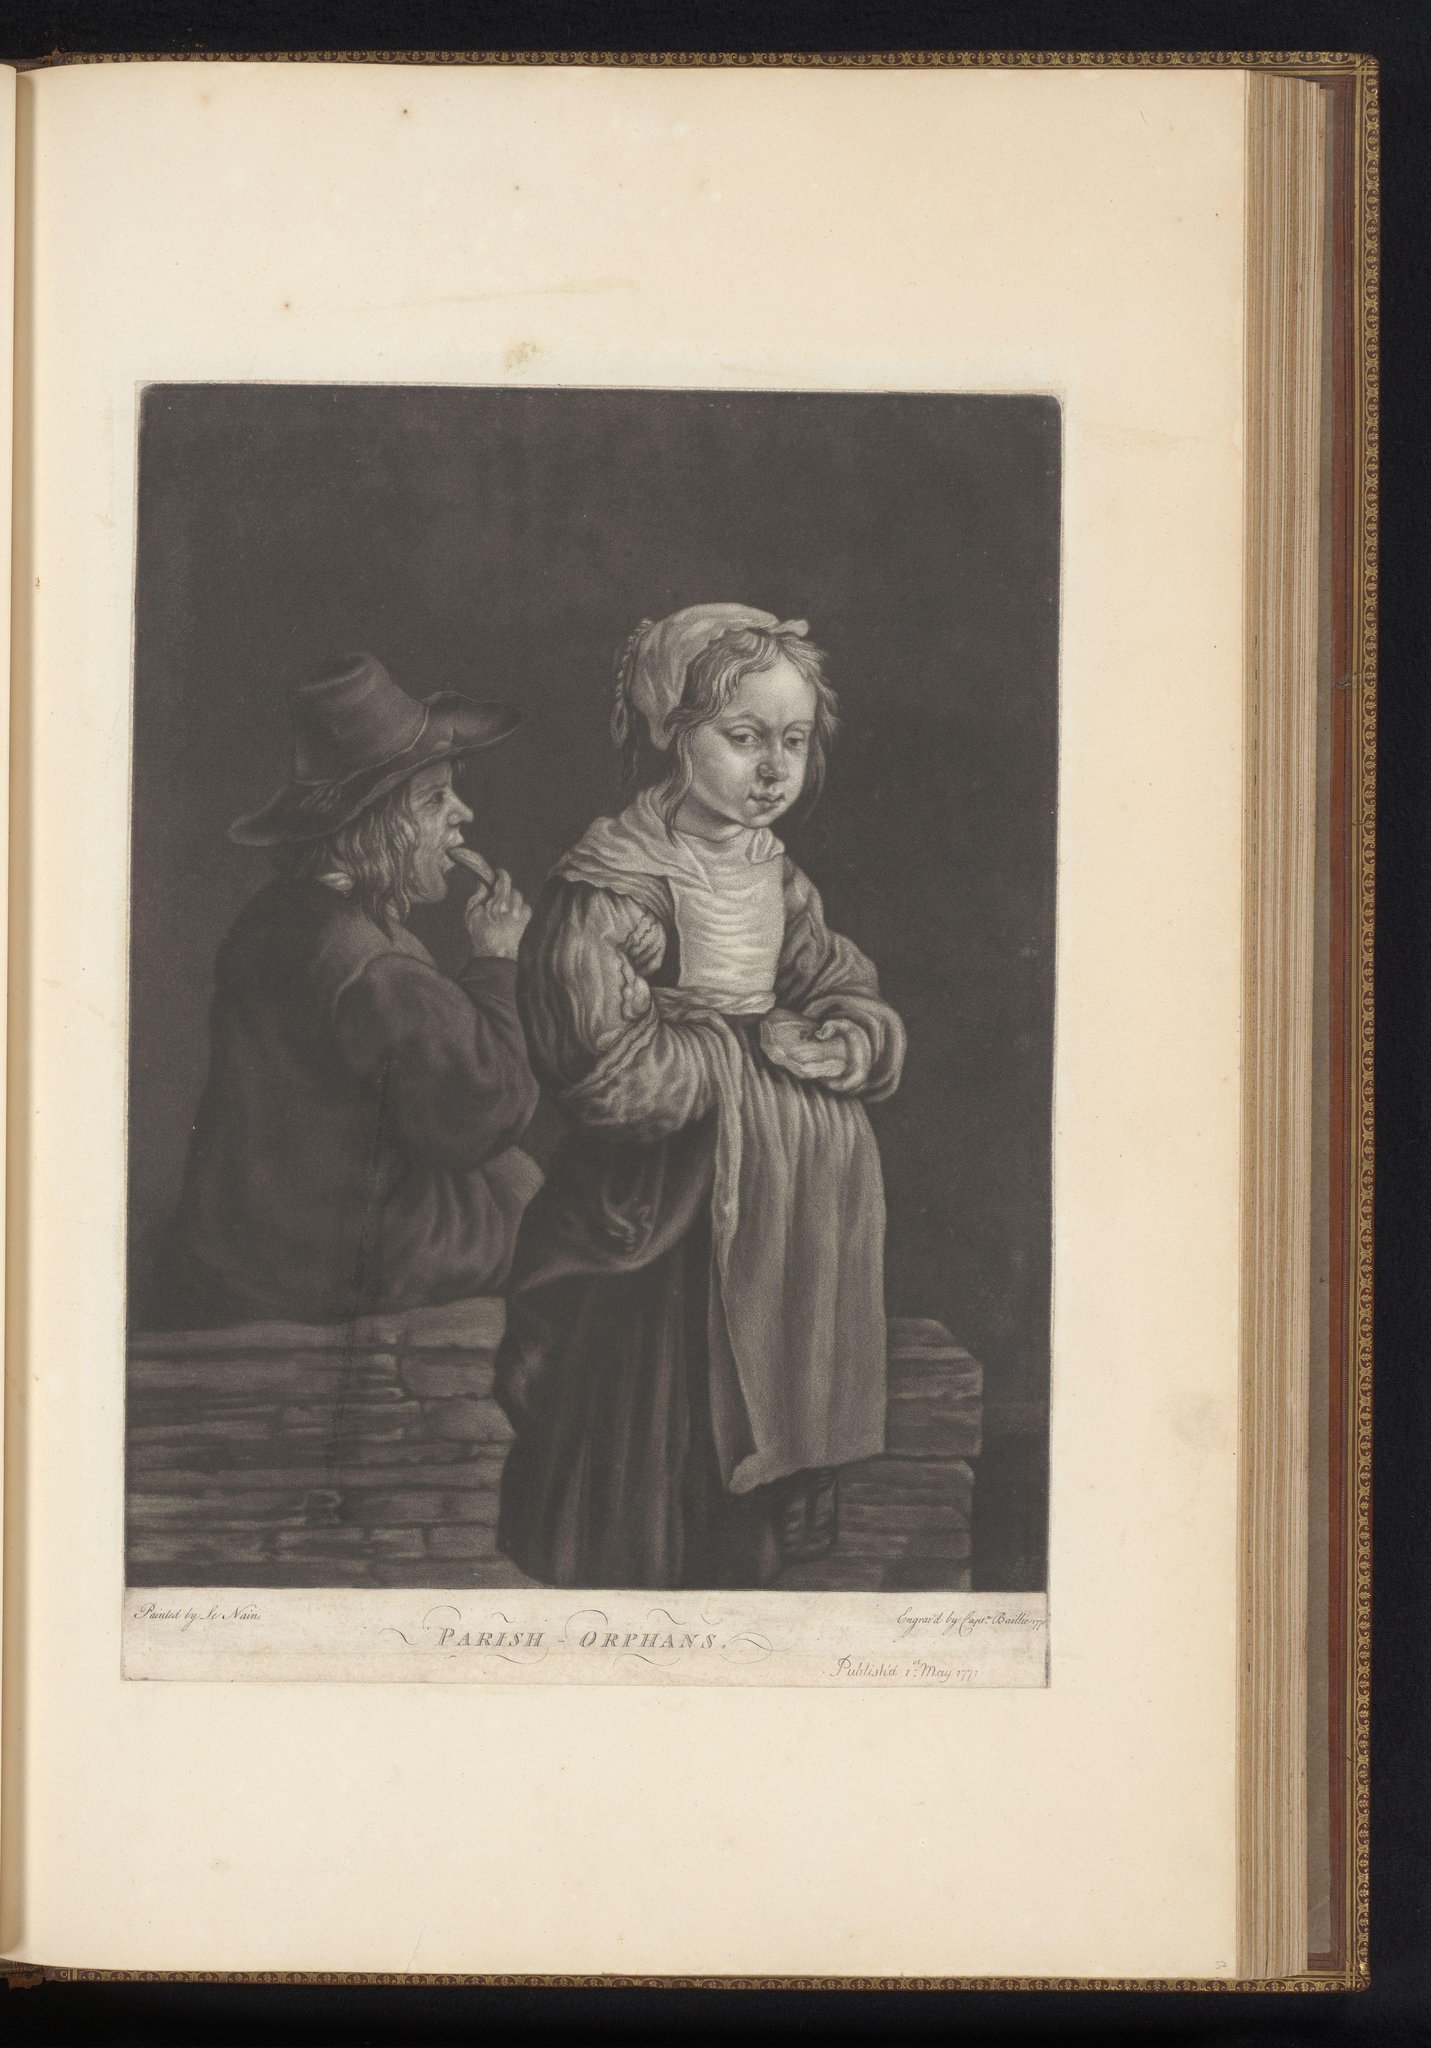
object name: print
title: Twee wezen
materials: paper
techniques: etching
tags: orphans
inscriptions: date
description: Twee wezen. Een jongen zit op een muur en eet een stuk brood. Een meisje heeft brood in haar hand. De prent maakt deel uit van een album.